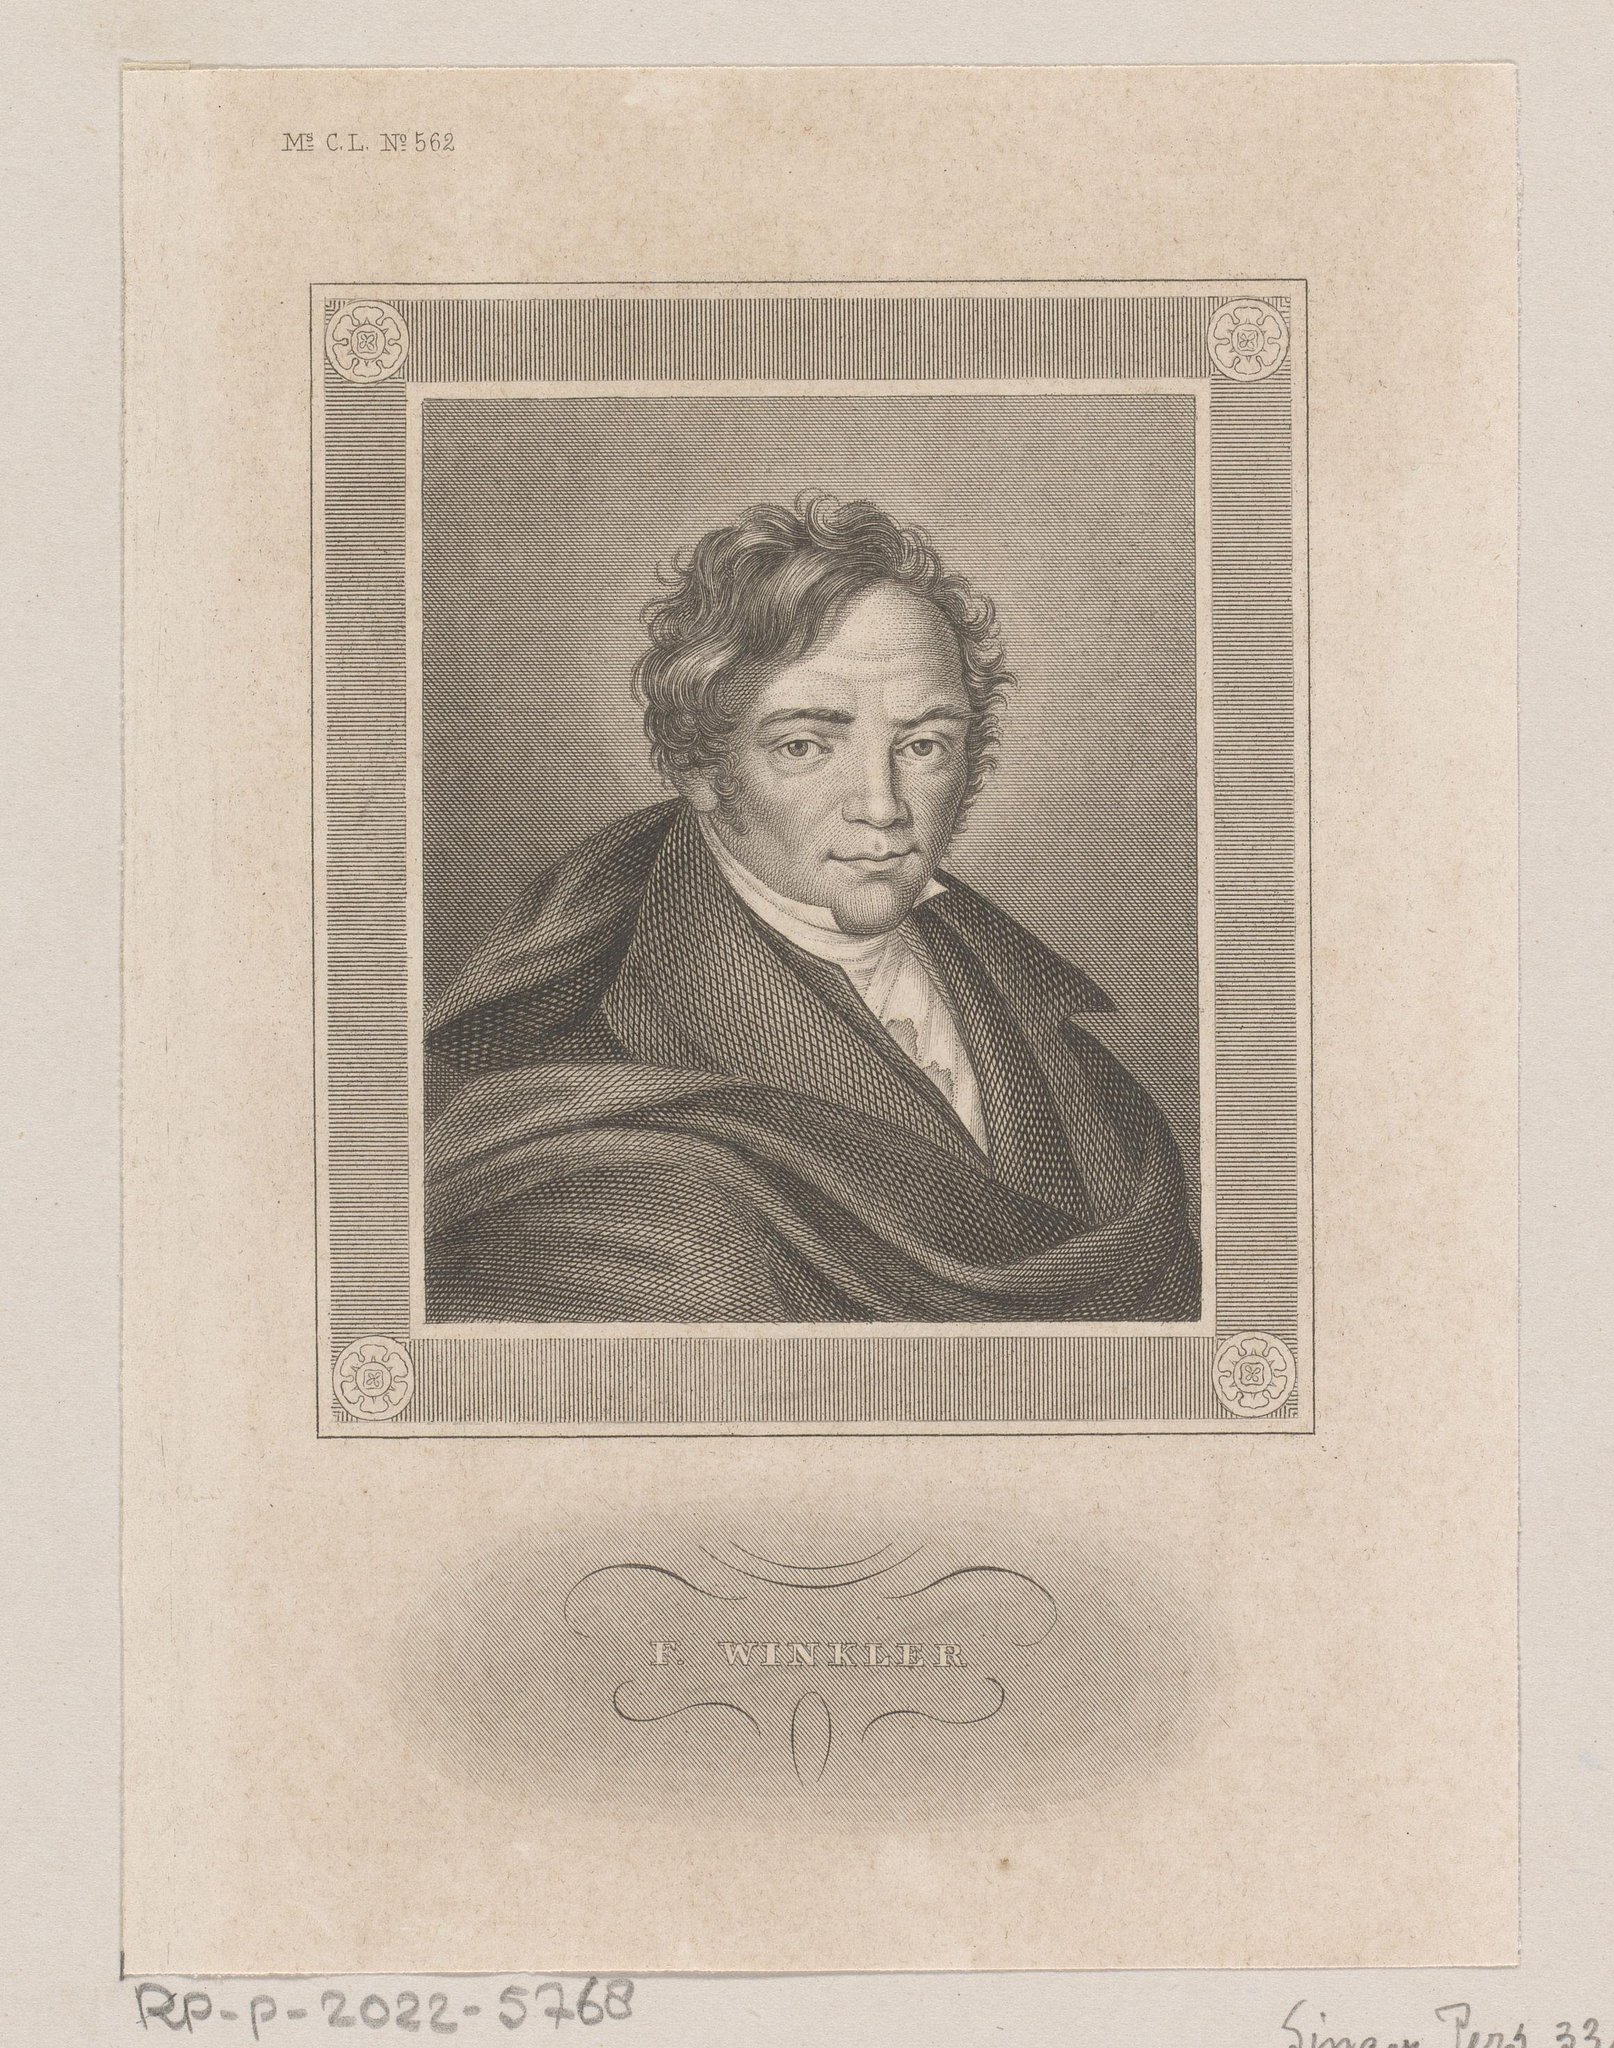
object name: print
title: Portret van Karl Gottfried Theodor Winkler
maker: Anonymous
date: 1839-1855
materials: paper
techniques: engraving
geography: germany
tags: historical persons, portrait of a writer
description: Prent waarschijnlijk uit: Meyer, Joseph. Das große Conversations-Lexikon für die gebildeten Stände. 52 dln. Hildburghausen: Bibliographisches Institut, [1839-1855].